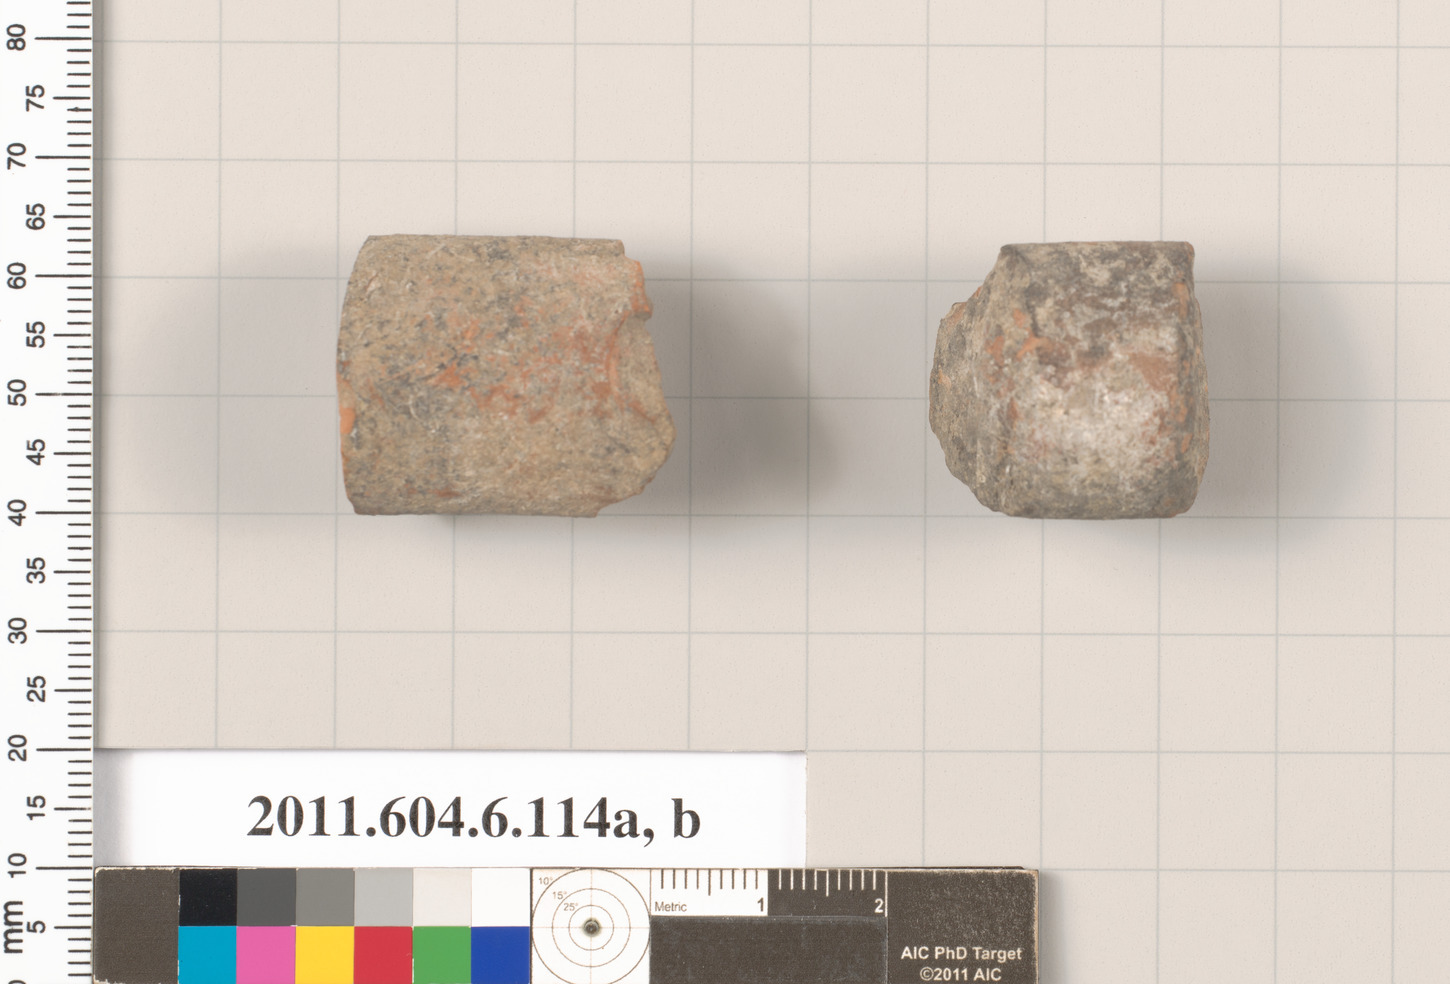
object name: undetermined shape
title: Terracotta fragments of undetermined shapes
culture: greek, attic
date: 600-401 BCE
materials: terracotta